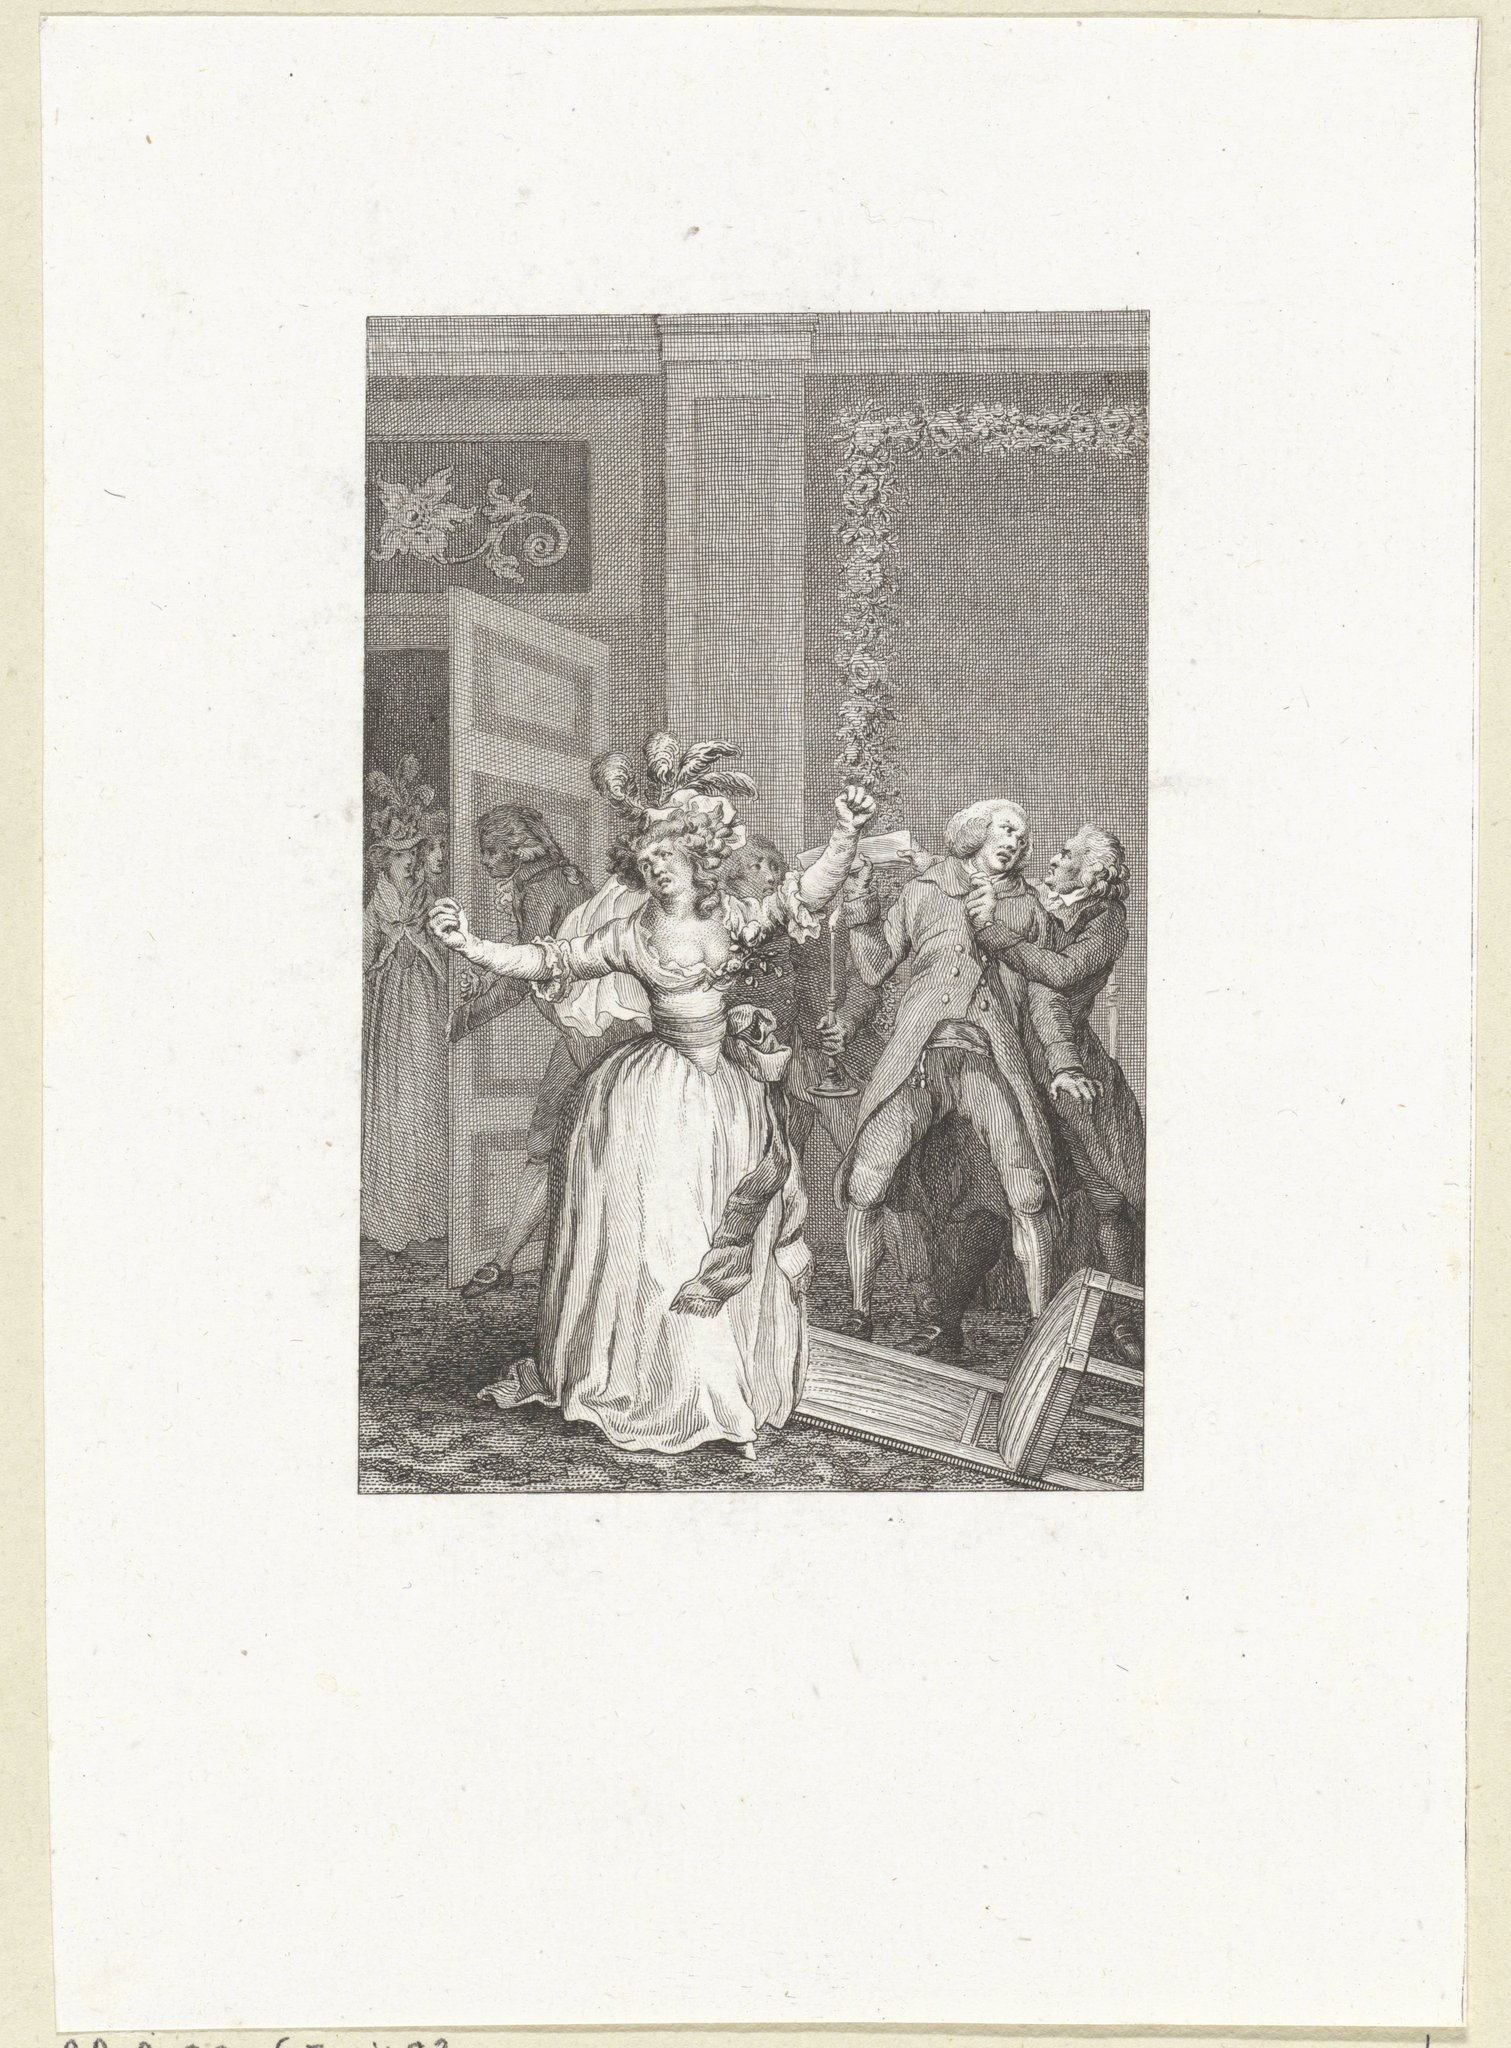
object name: print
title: Ruzie in een vertrek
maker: reinier vinkeles (i)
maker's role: draughtsman, print maker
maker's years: 1741-1816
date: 1794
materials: paper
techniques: engraving, etching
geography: amsterdam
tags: arm raised, with fist, aggressive relationships, enmity, animosity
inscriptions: collector's mark: Lugt 240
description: Proefdruk van een prent die mogelijk ook gebruikt is als illustratie in: Holcroft, Thomas. Dornton of De jeugdige losheid en Uitspoorige kinderliefde. Amsterdam: erven van Pieter Meĳer en Gerrit Warnars, 1794.